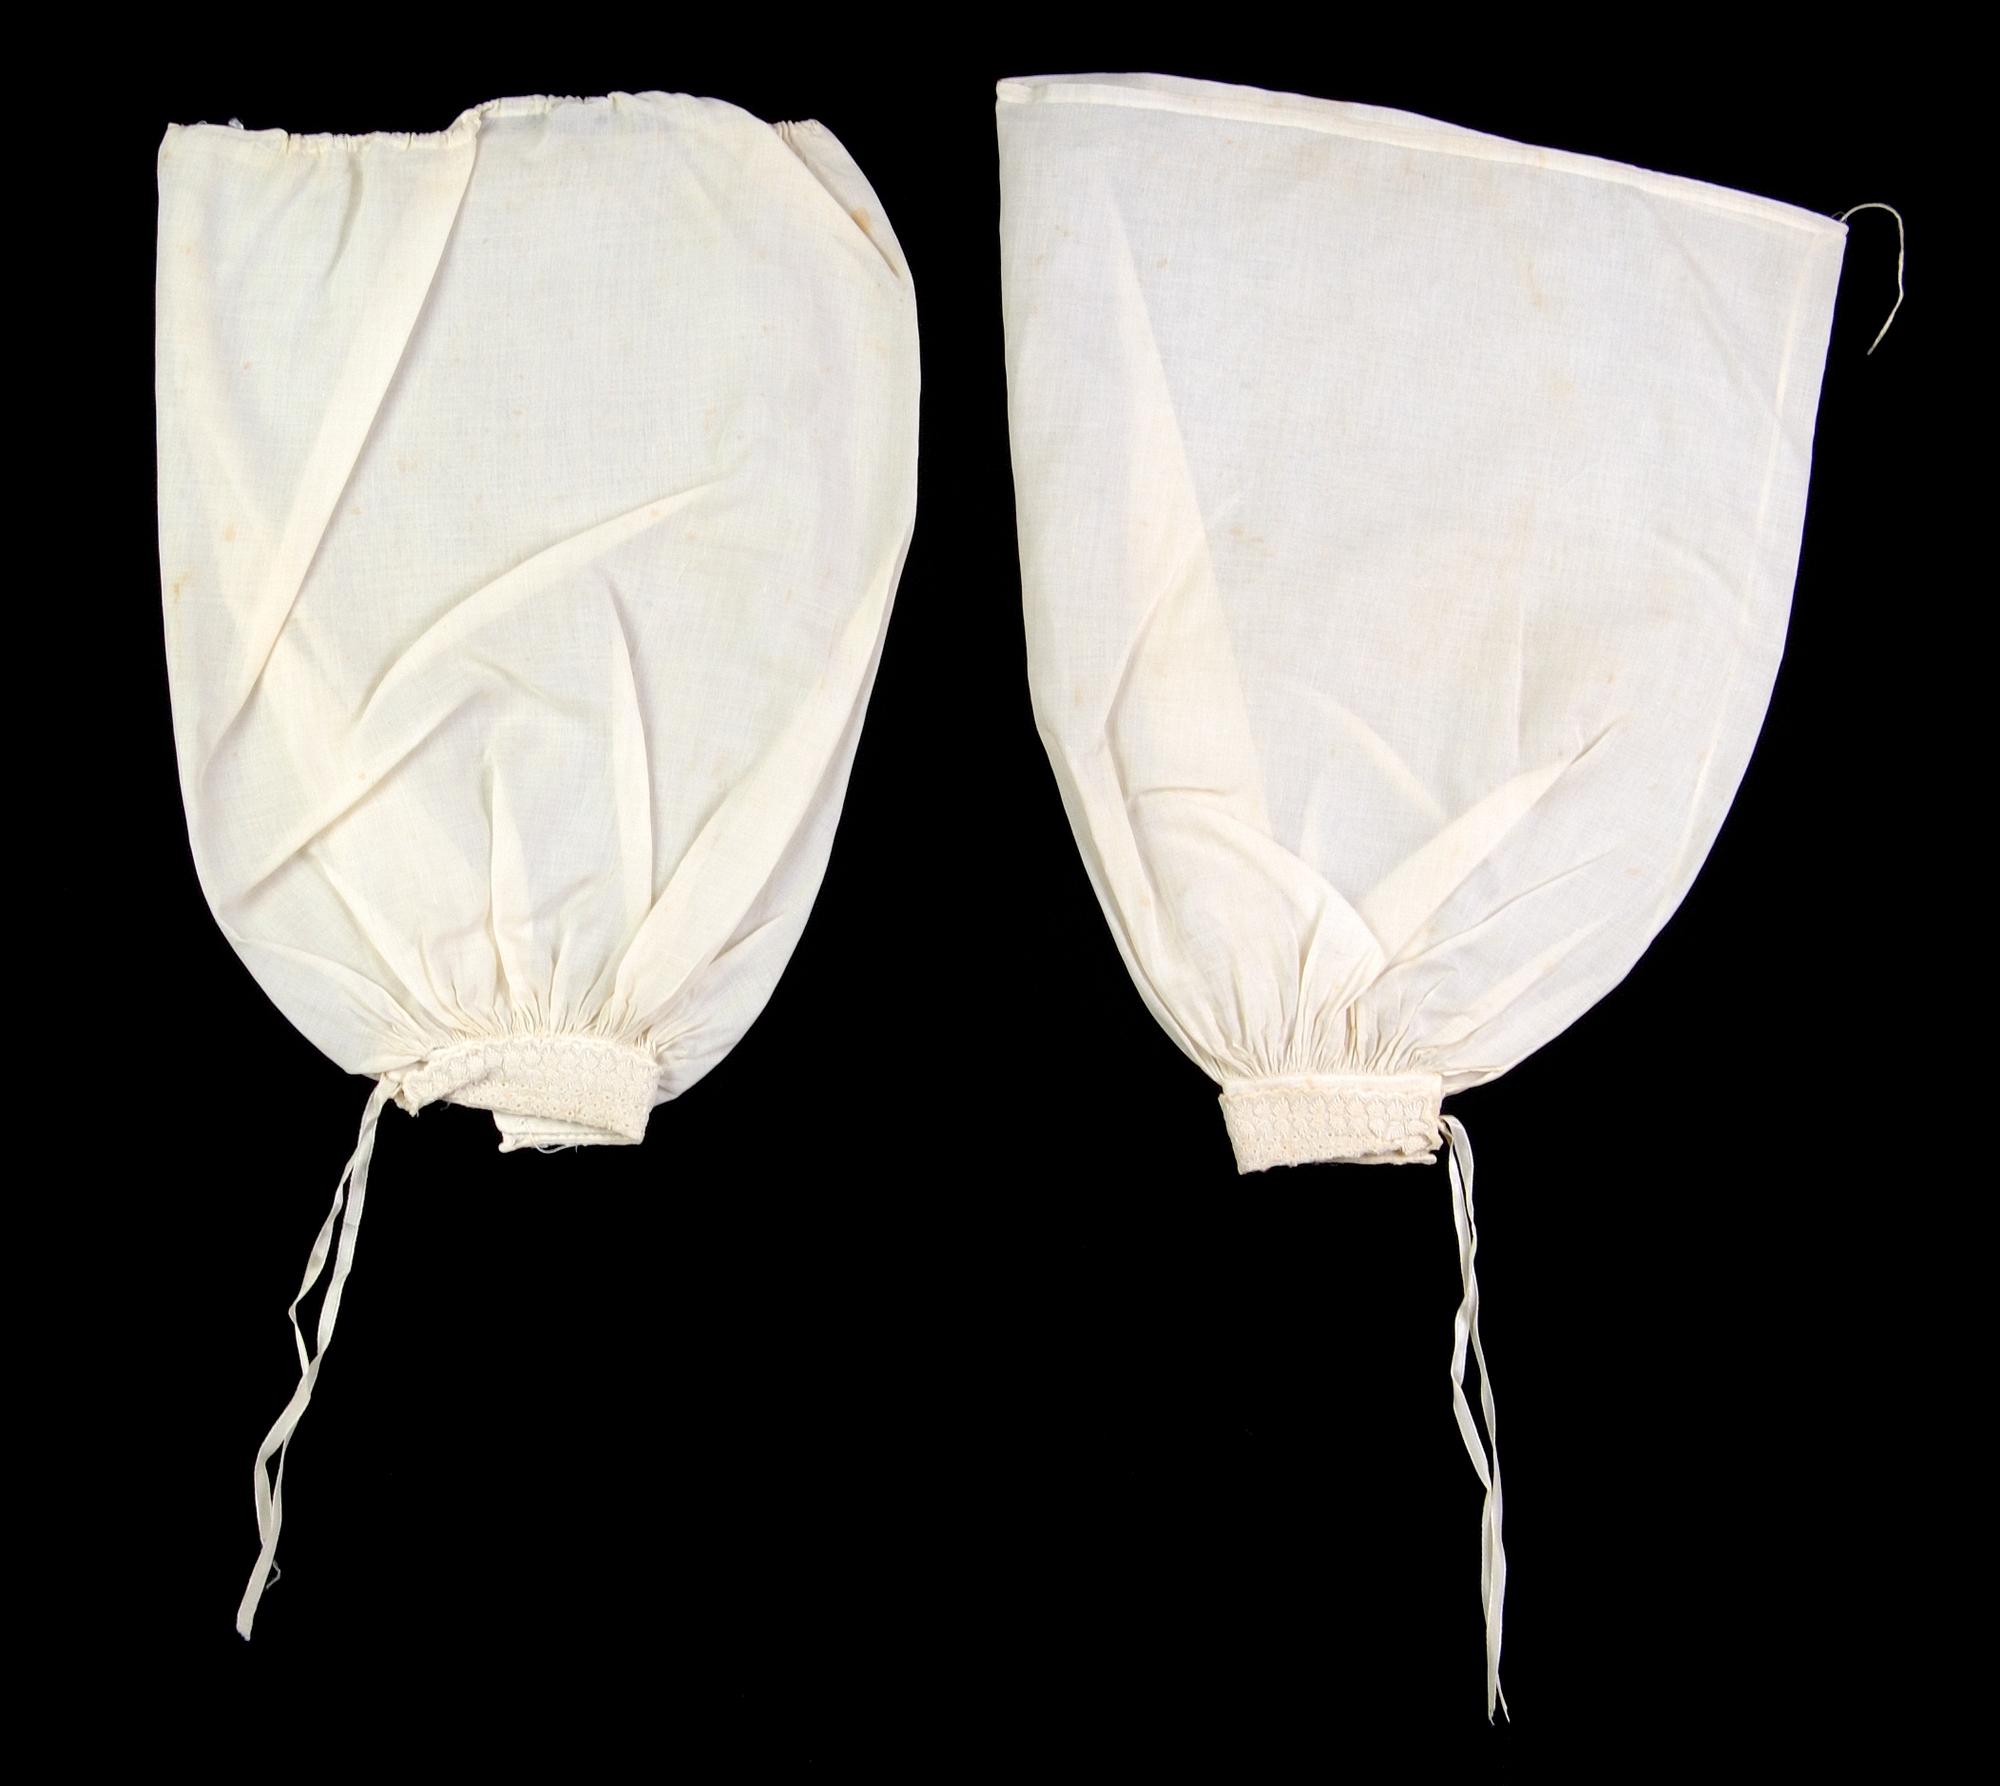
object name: undersleeves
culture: american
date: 1860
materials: cotton